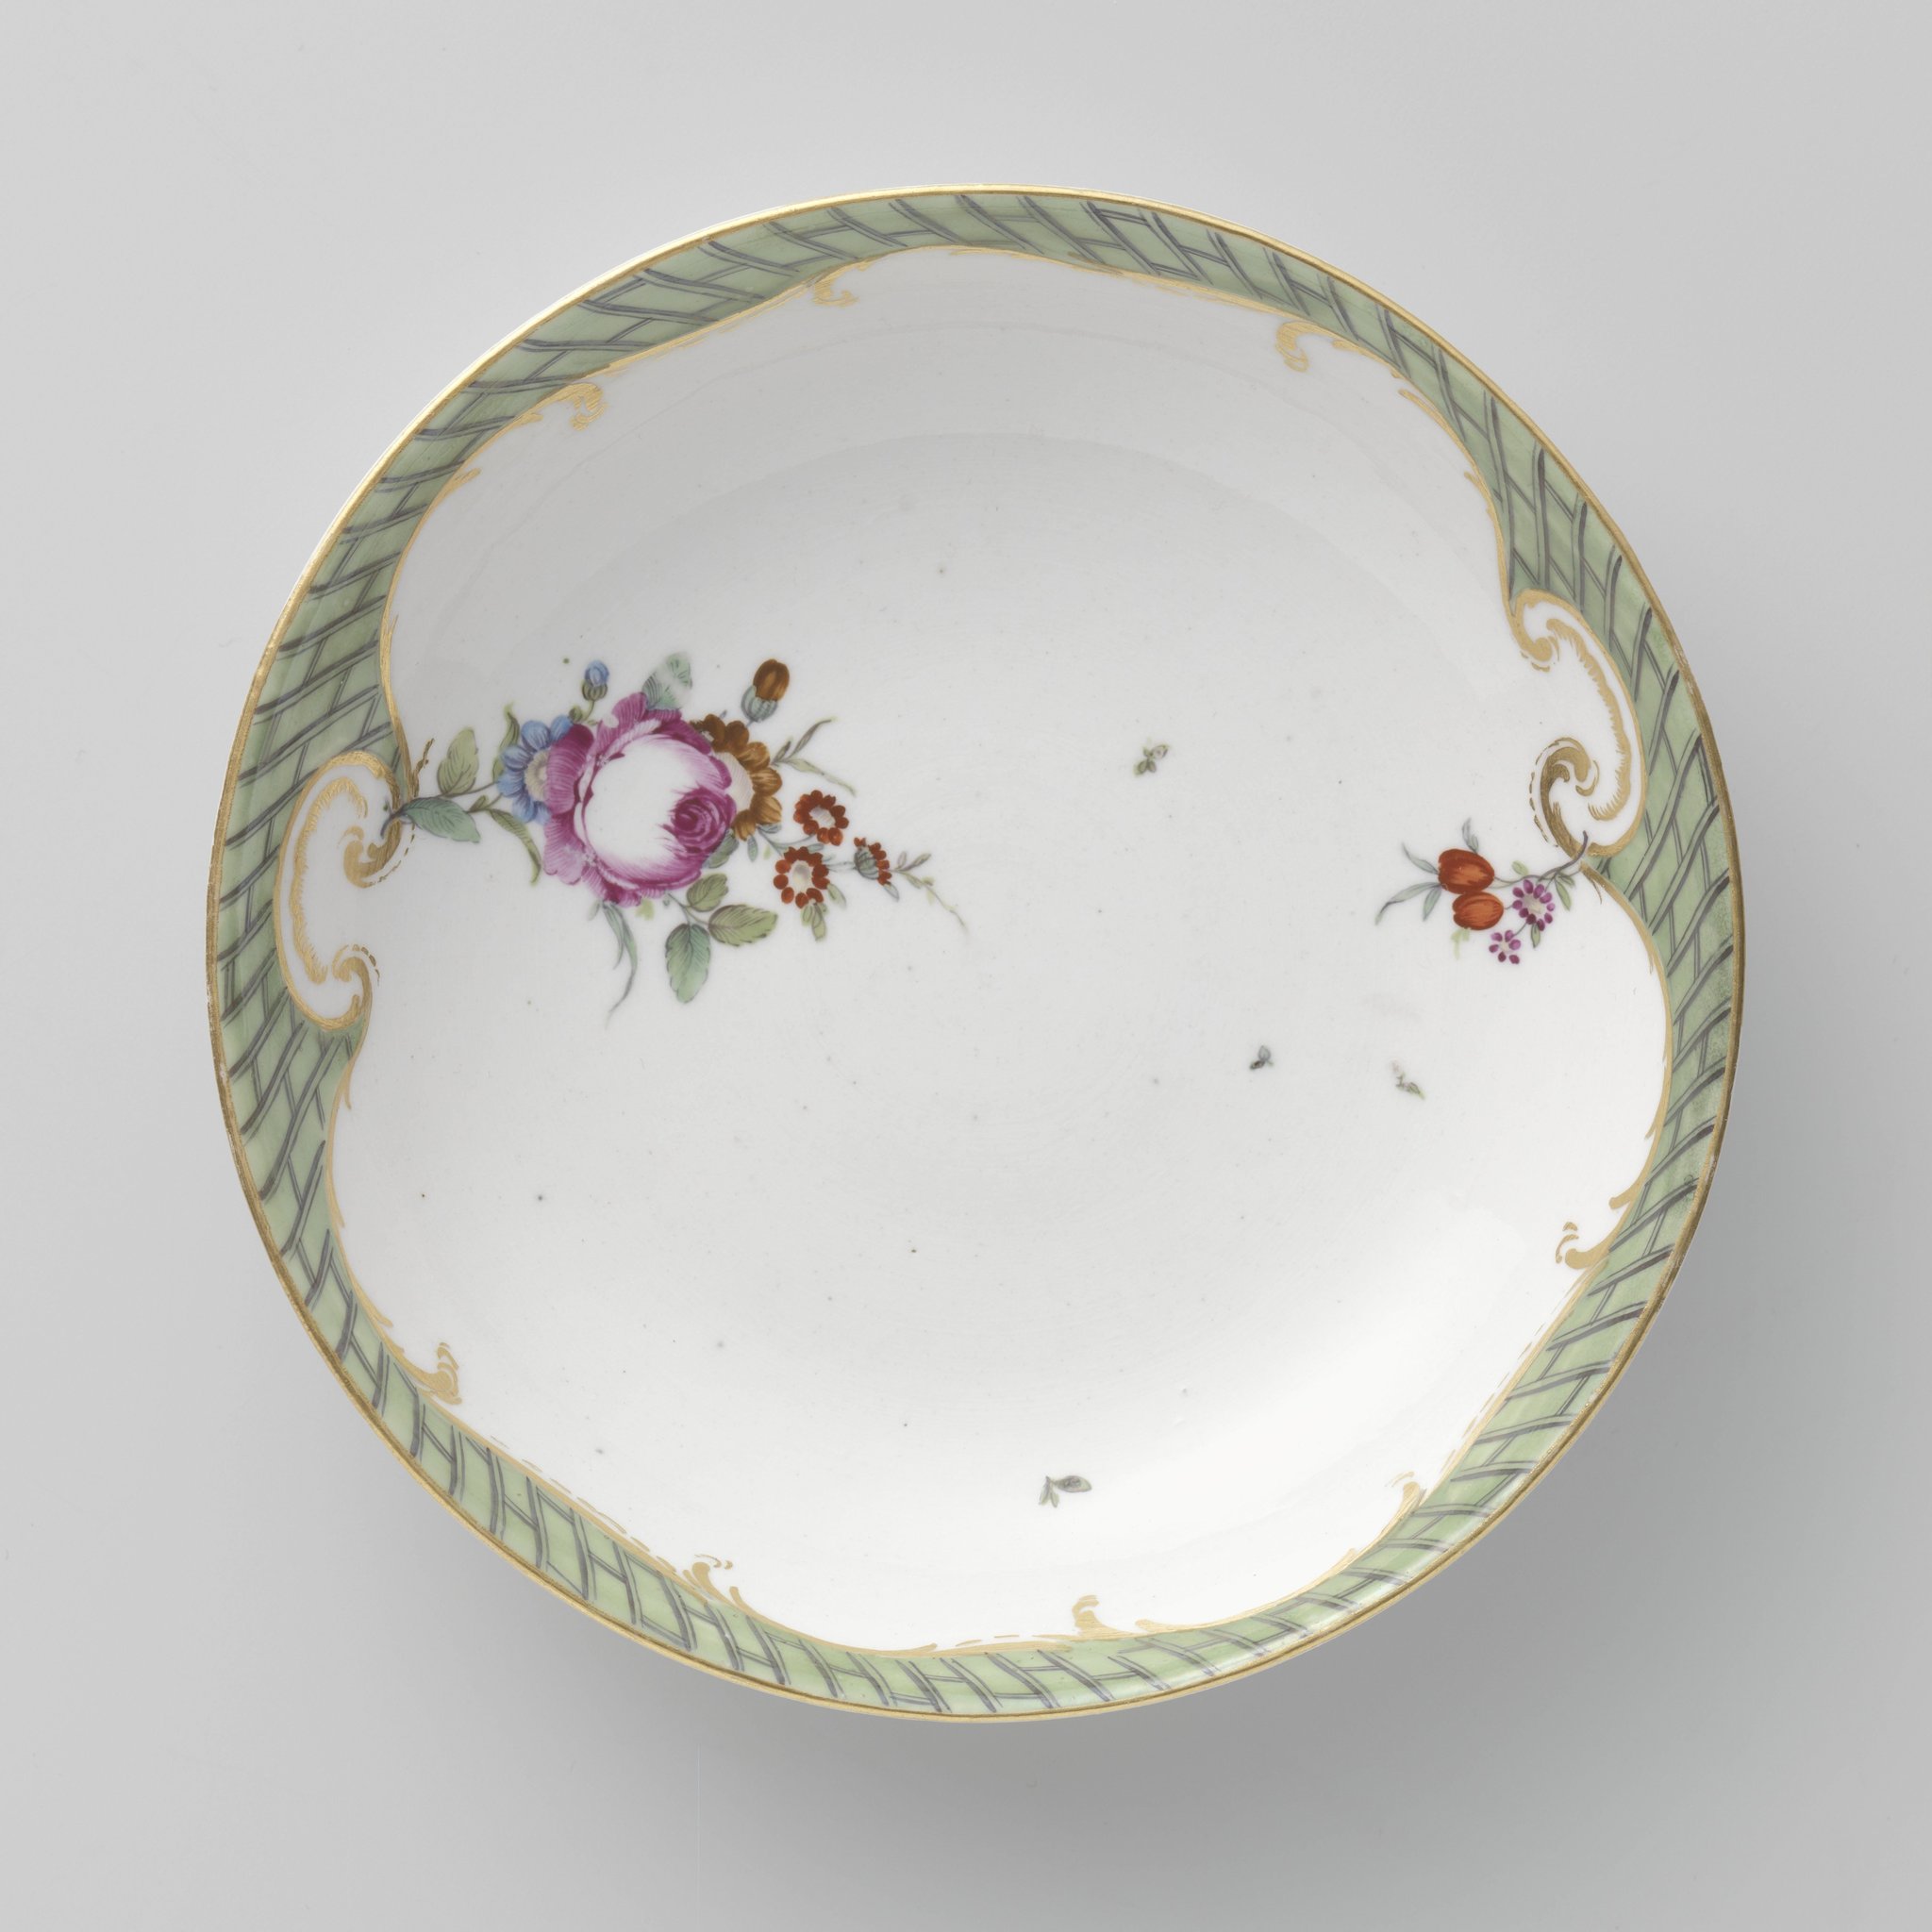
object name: platter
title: Schotel, beschilderd met bloemen en laddermotief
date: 1775-1778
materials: porcelain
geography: loosdrecht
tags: flowers ~ ornament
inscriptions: mark: ‘L2’, factory mark: ‘M:OL’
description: Schotel van porselein. Veelkleurig beschilderd met bloemboeketten en een laddermotief langs de randen.